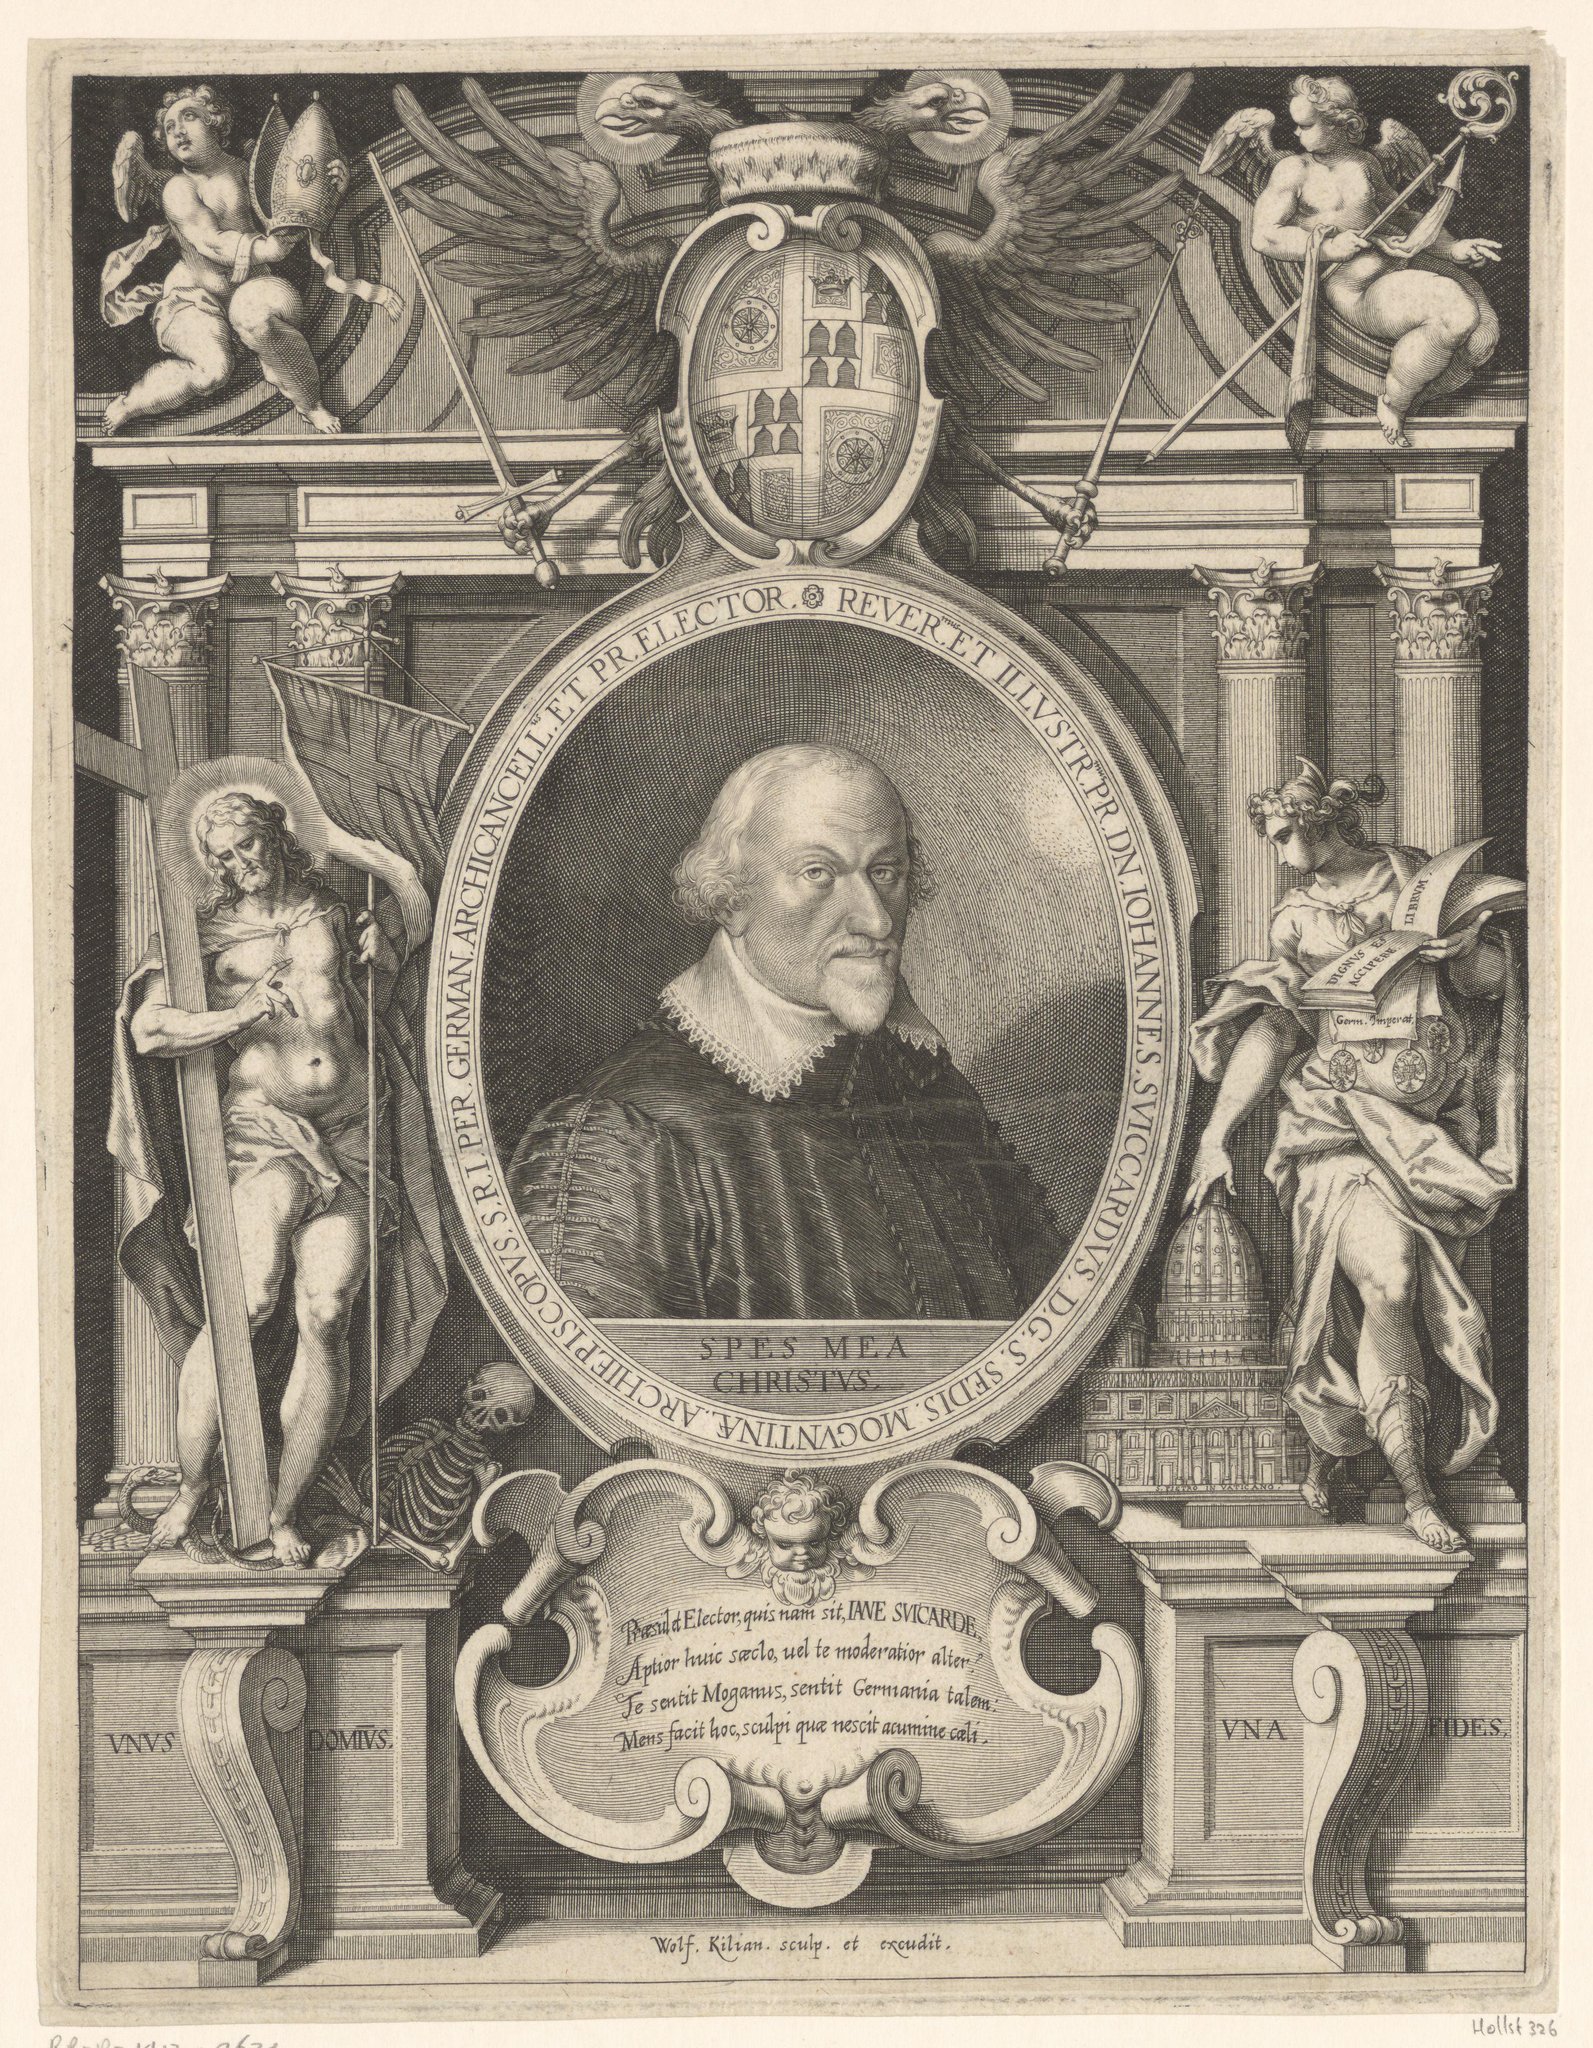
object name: print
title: Portret van Johann Schweikhard von Kronberg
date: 1604-1662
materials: paper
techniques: engraving, etching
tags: johann schweikhard von kronberg, archbishop, bishop, etc. (roman catholic), historical persons, allegorical and symbolical representations ~ the church and religion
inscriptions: collector's mark: Lugt 2228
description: Tekst in het Latijn in de omlijsting, op de sokkels en in de cartouche. Om het medaillon een allegorie op religie.